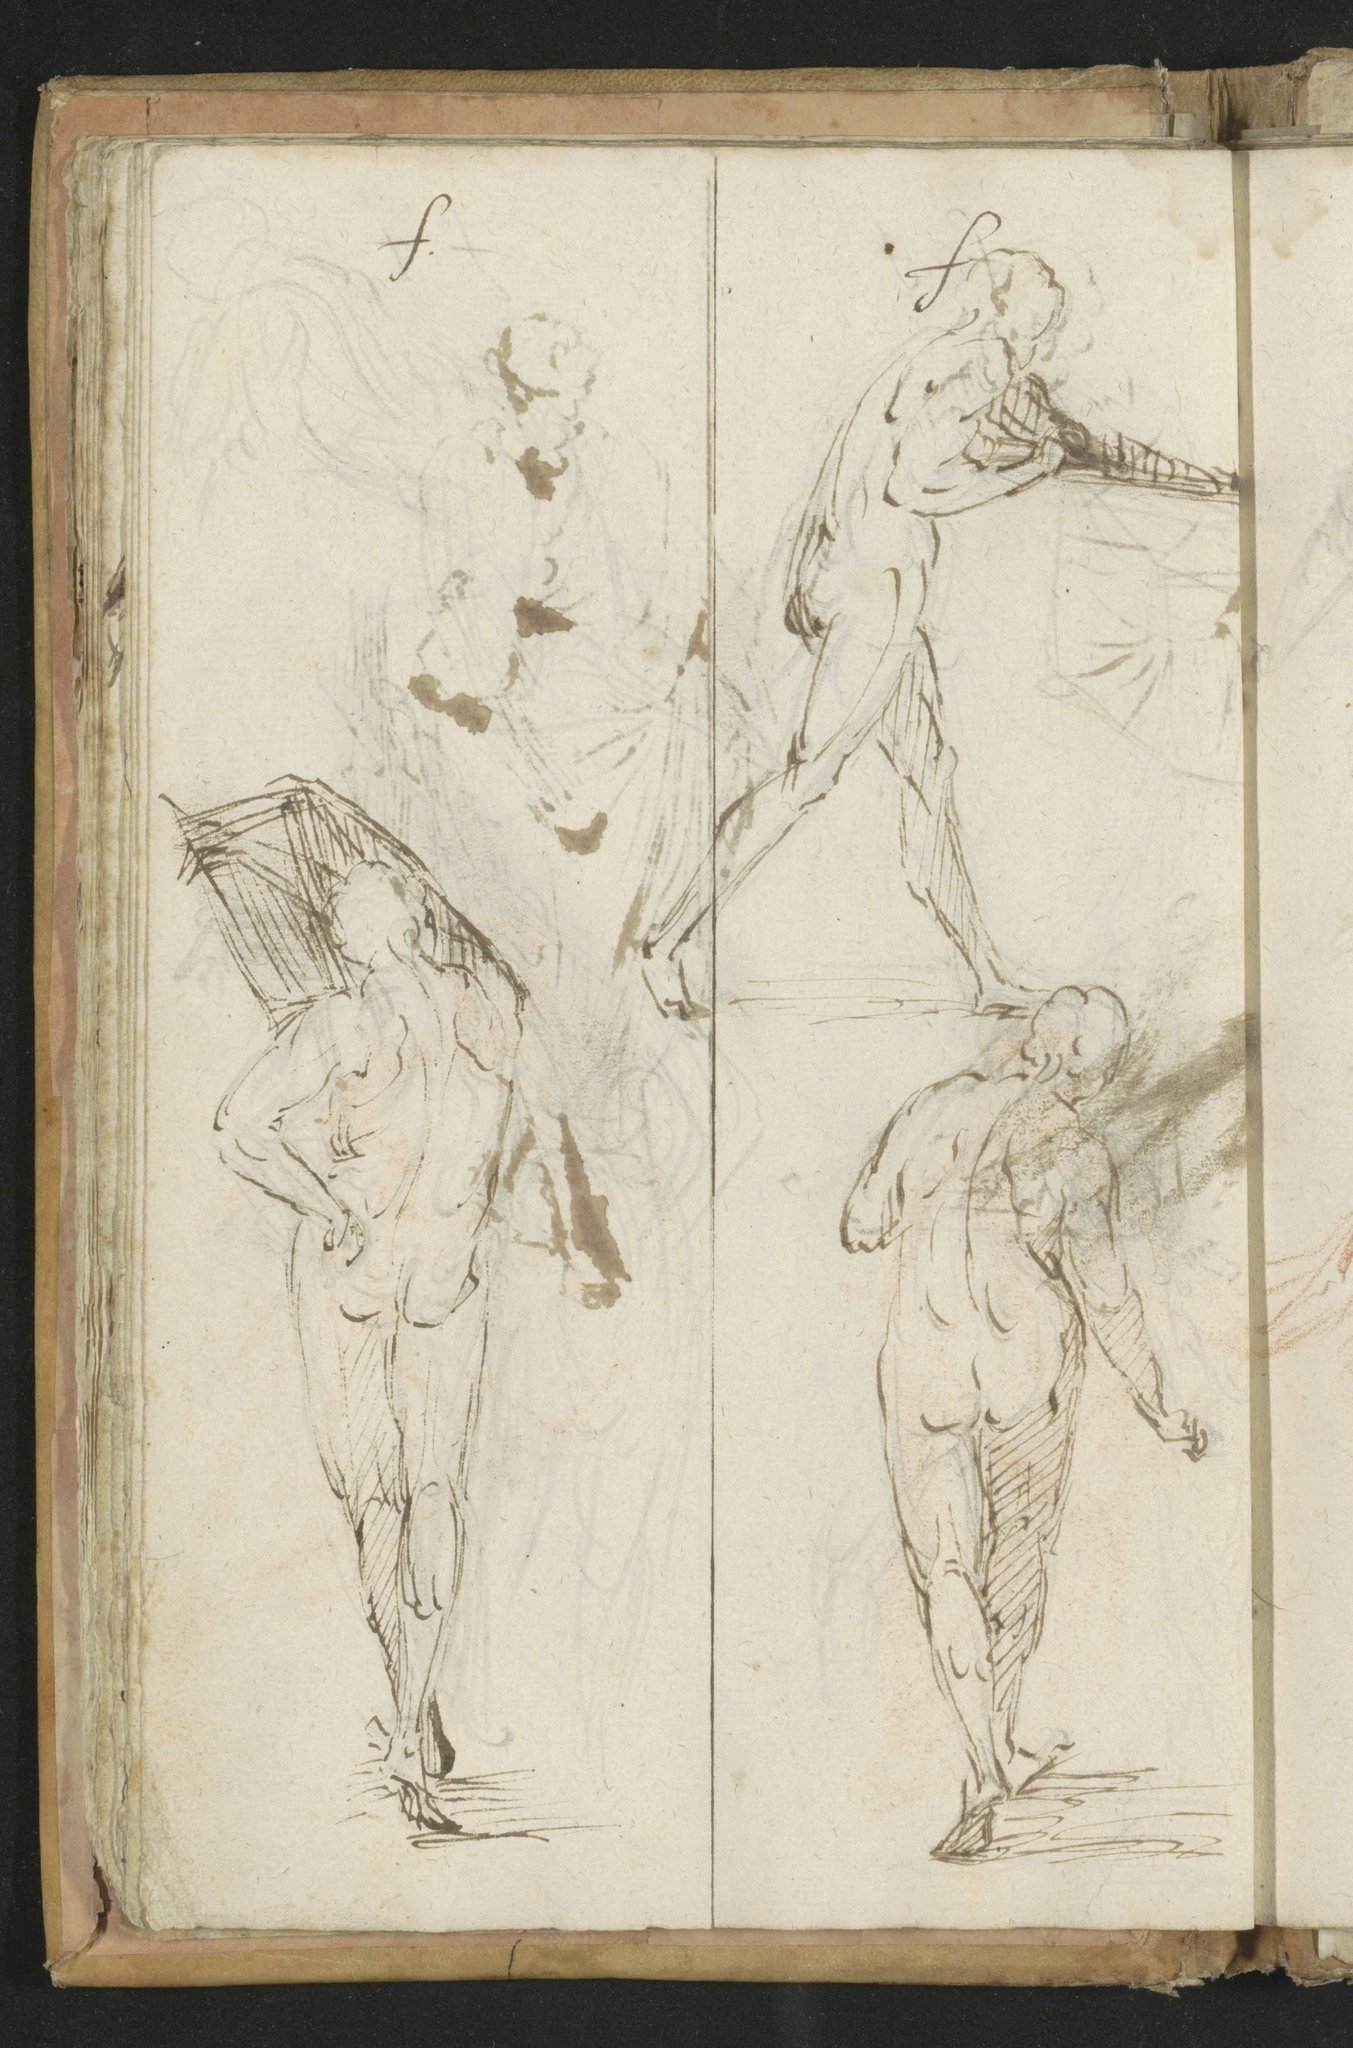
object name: sketchbook leaf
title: Drie lopende naakte mannen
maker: Anonymous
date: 1658-1728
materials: ink, paper, pencil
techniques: pen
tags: the (nude) human figure; 'corpo humano' (ripa), walking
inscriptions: annotation: ‘f f’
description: Tevens een studie van een voorovergebogen naakte man. Blad 12 verso uit een schetsboek met 33 bladen.